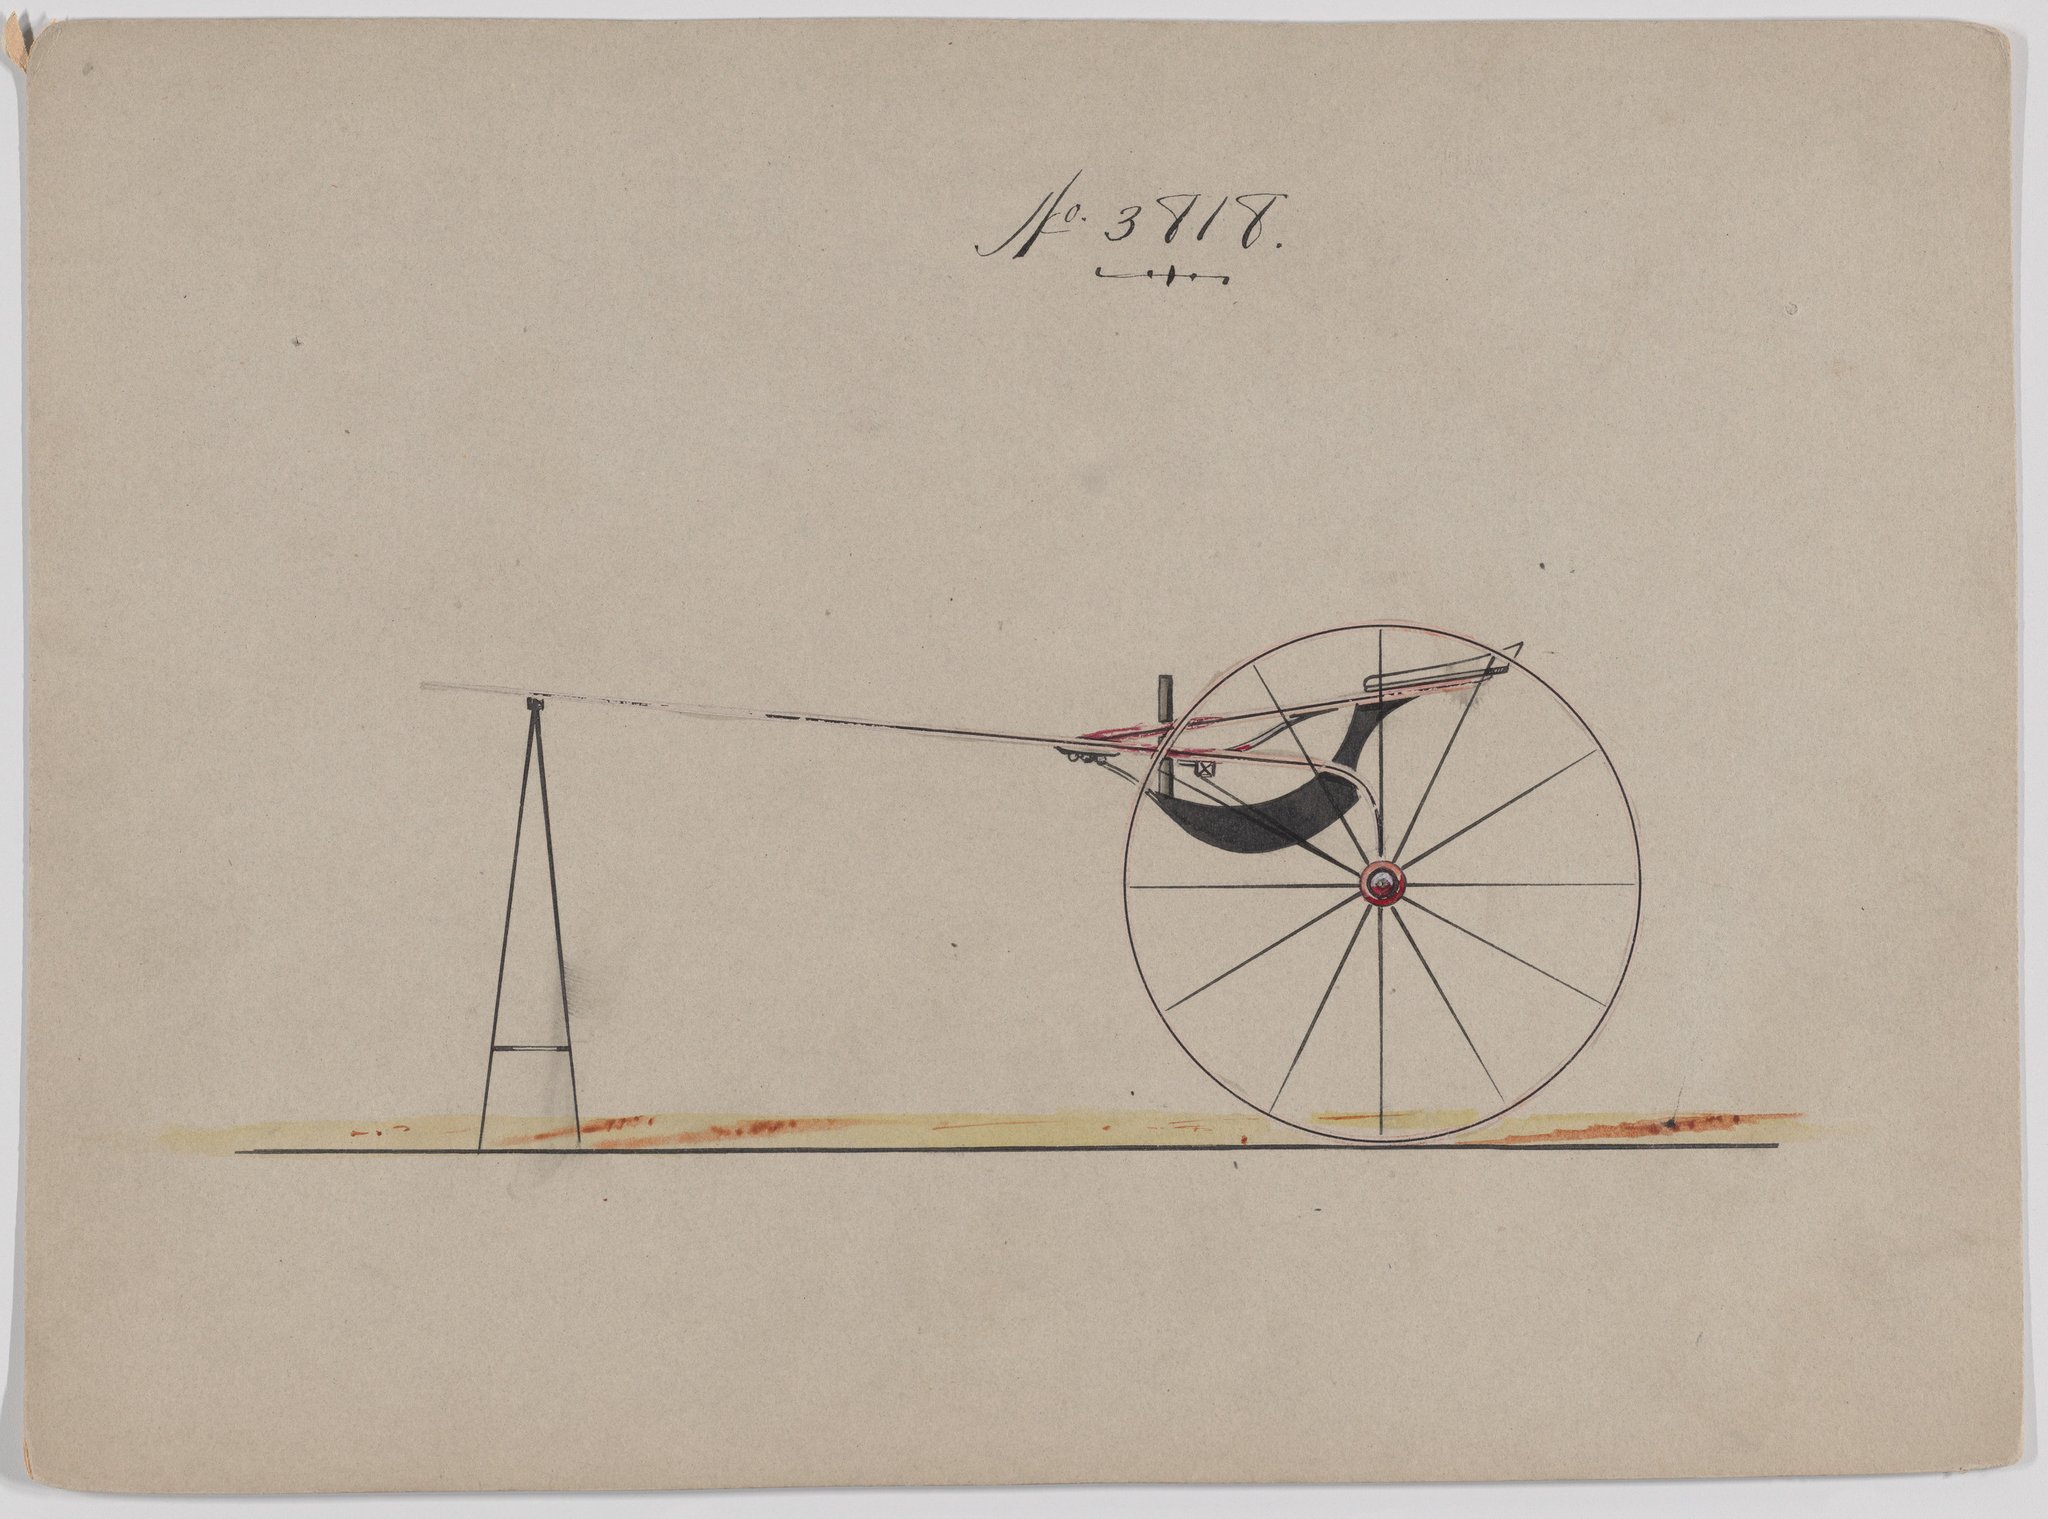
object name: collection ornament architecture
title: Design for Dog Cart or 2 Wheeler, no. 3818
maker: brewster & co.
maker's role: manufacturer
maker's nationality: american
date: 1883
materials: gouache, gum arabic, ink, watercolor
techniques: pen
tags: carriages